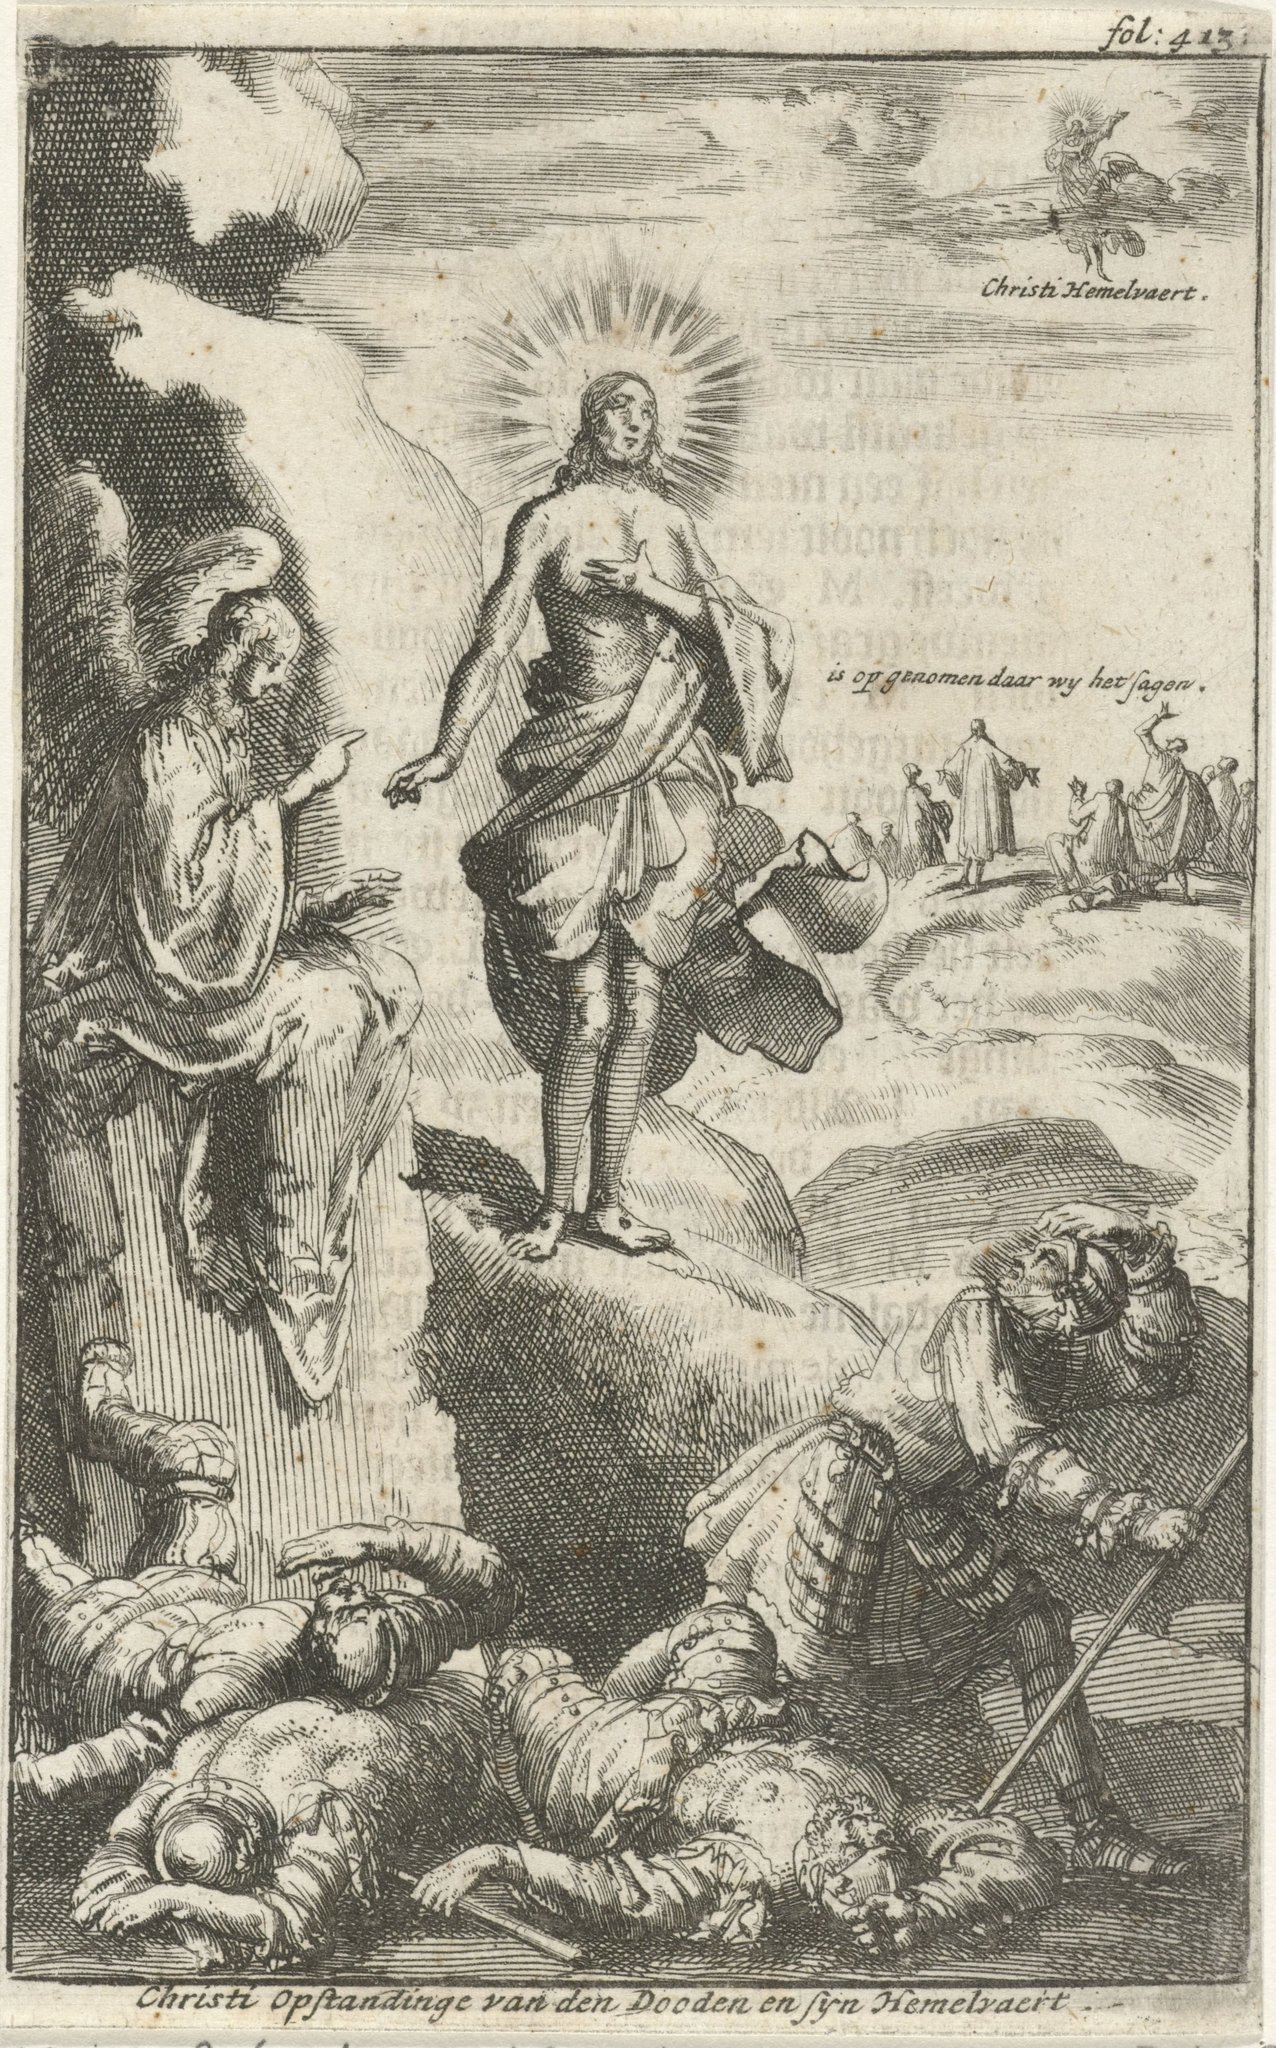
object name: book illustration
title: Christi Opstandinge van den Dooden en syn Hemelvaert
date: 1690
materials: paper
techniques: etching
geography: amsterdam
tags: resurrection of christ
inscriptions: collector's mark: Lugt 2228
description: Illustratie uit: Garthwait, Henry. Historie des levens en stervens onses Heeren en saligmakers Jesu Christi. Amsterdam: Jan Claesz ten Hoorn, 1690.